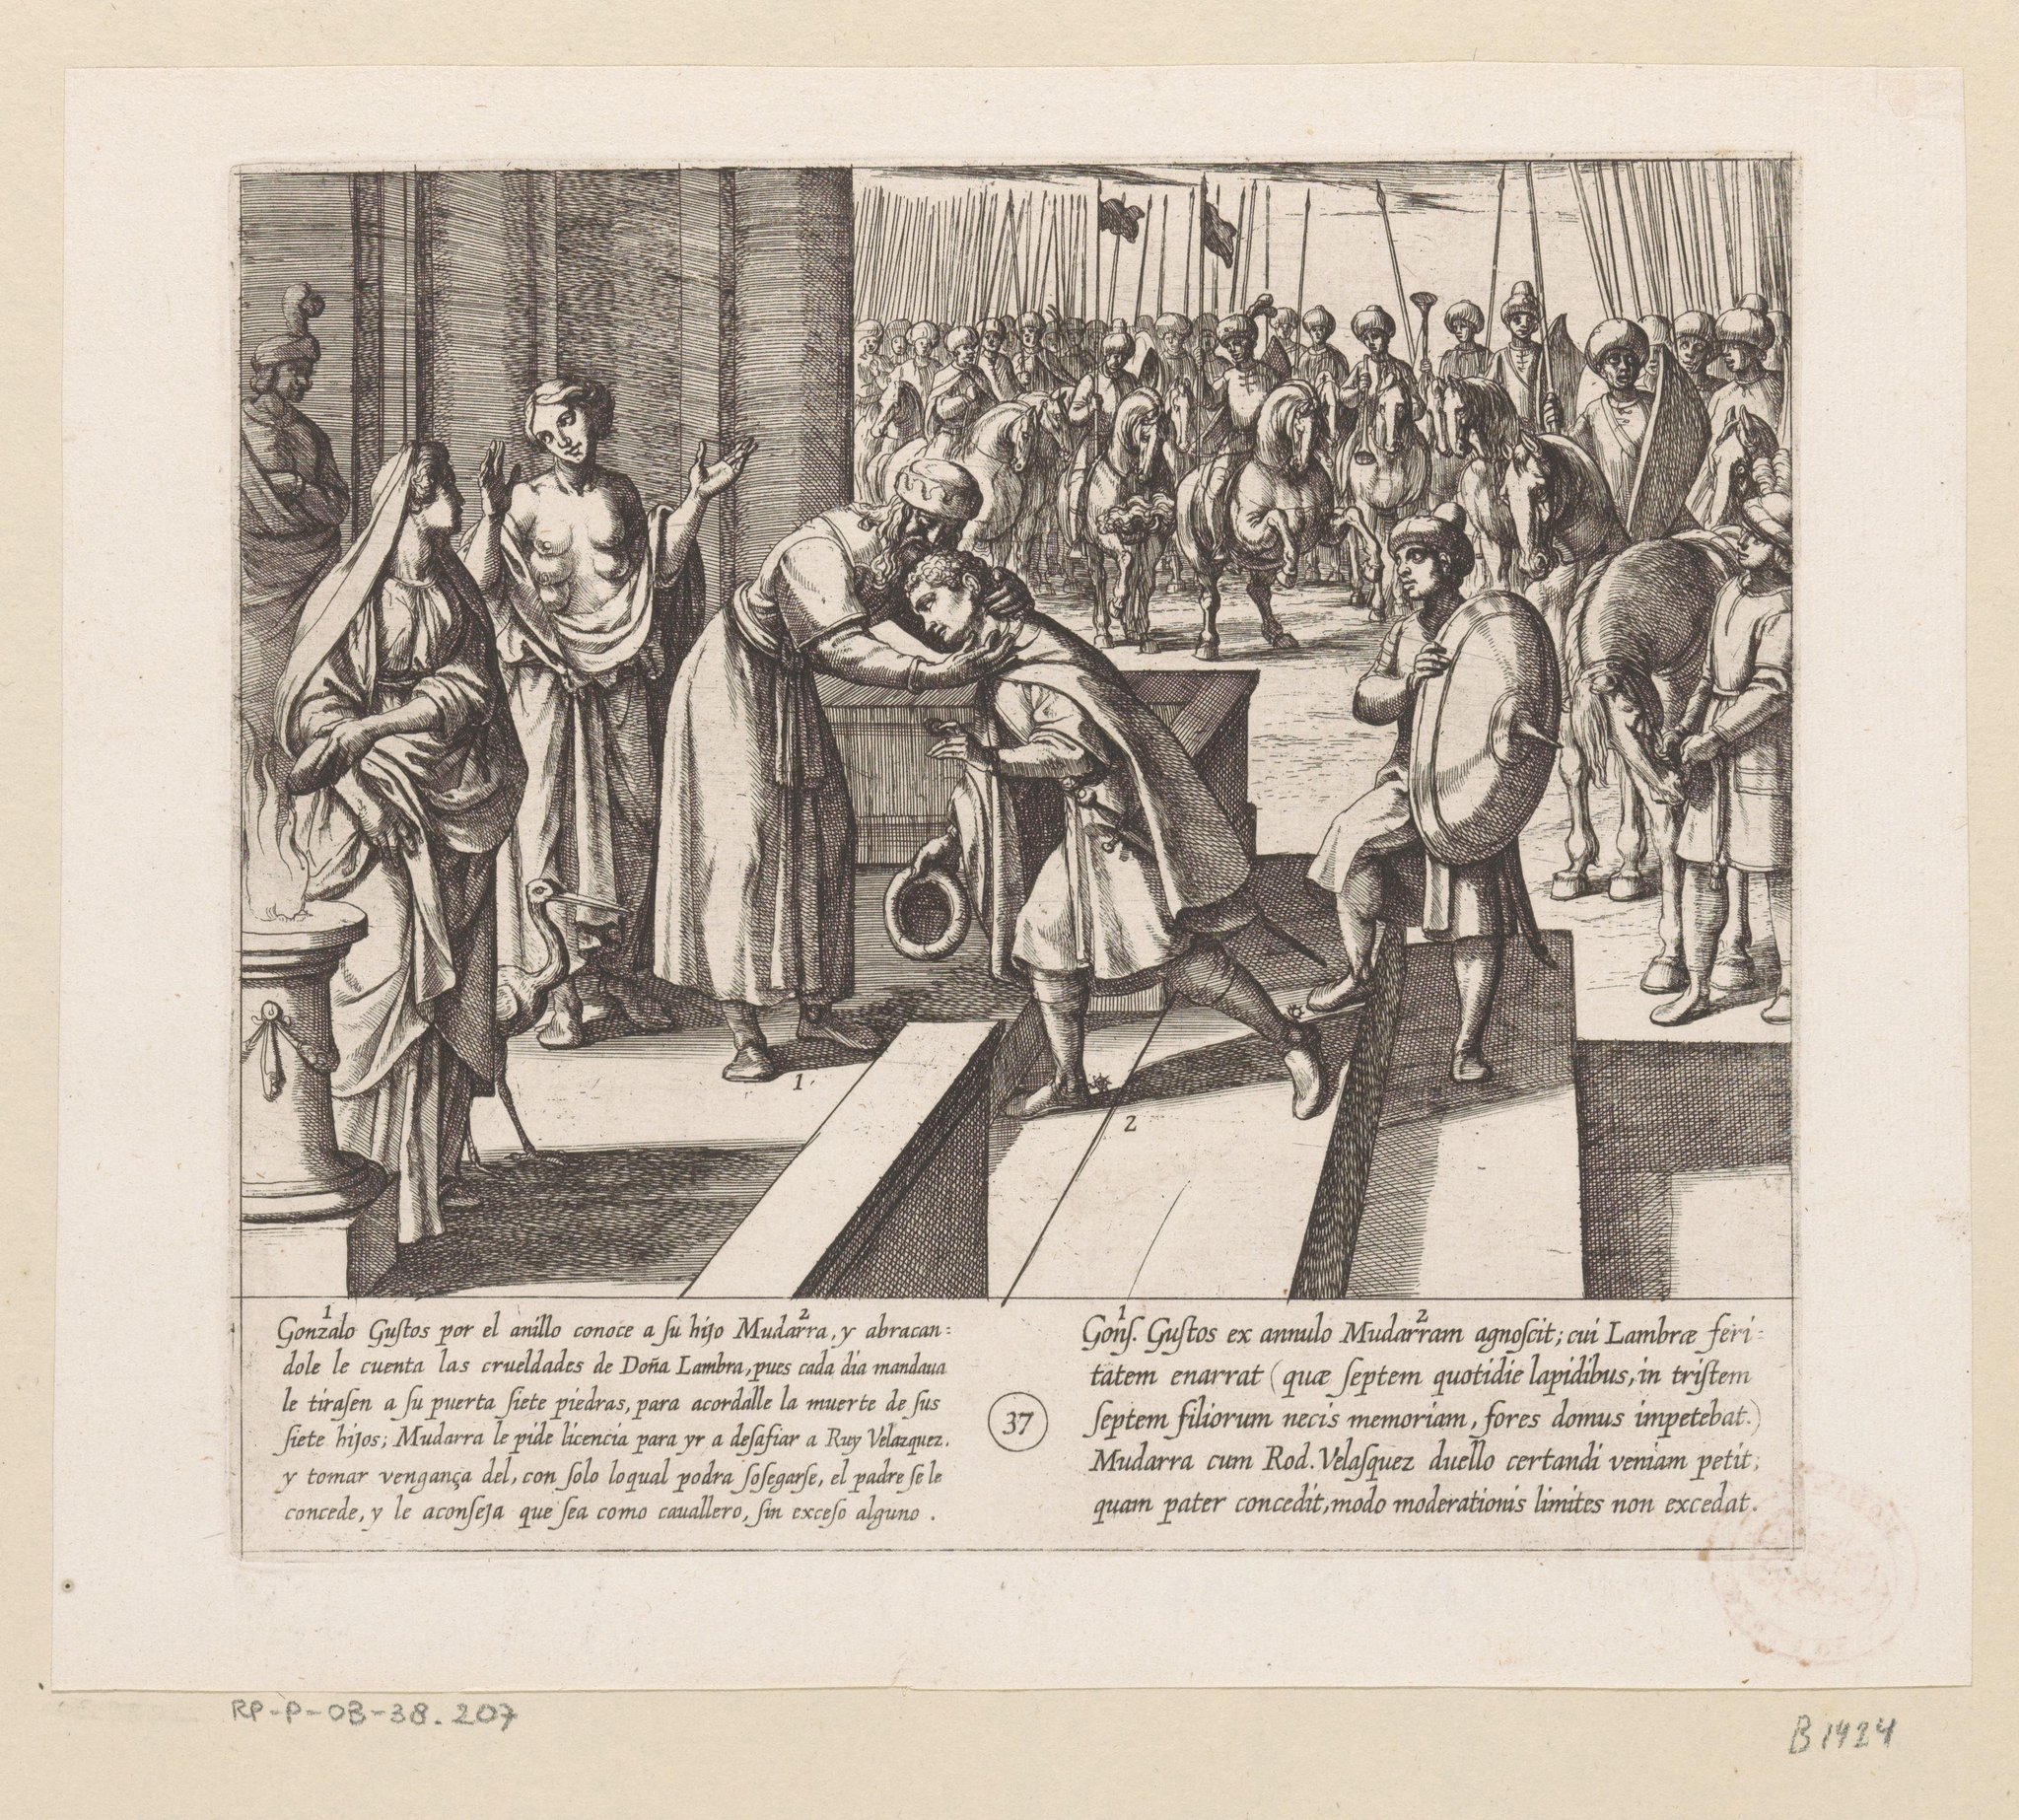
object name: print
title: Historia Septem Infantium de Lara/ Historia de los Siete Infantes de Lara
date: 1612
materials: paper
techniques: etching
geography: antwerp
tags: warfare; military affairs (+ cavalry, horsemen), tales and fairy tales, ring, recognizing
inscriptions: collector's mark: Lugt 240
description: Deze prent maakt deel uit van een reeks van 40 prenten (+ titelprent) met voorstellingen uit het volksverhaal over de zeven infanten van Lara.